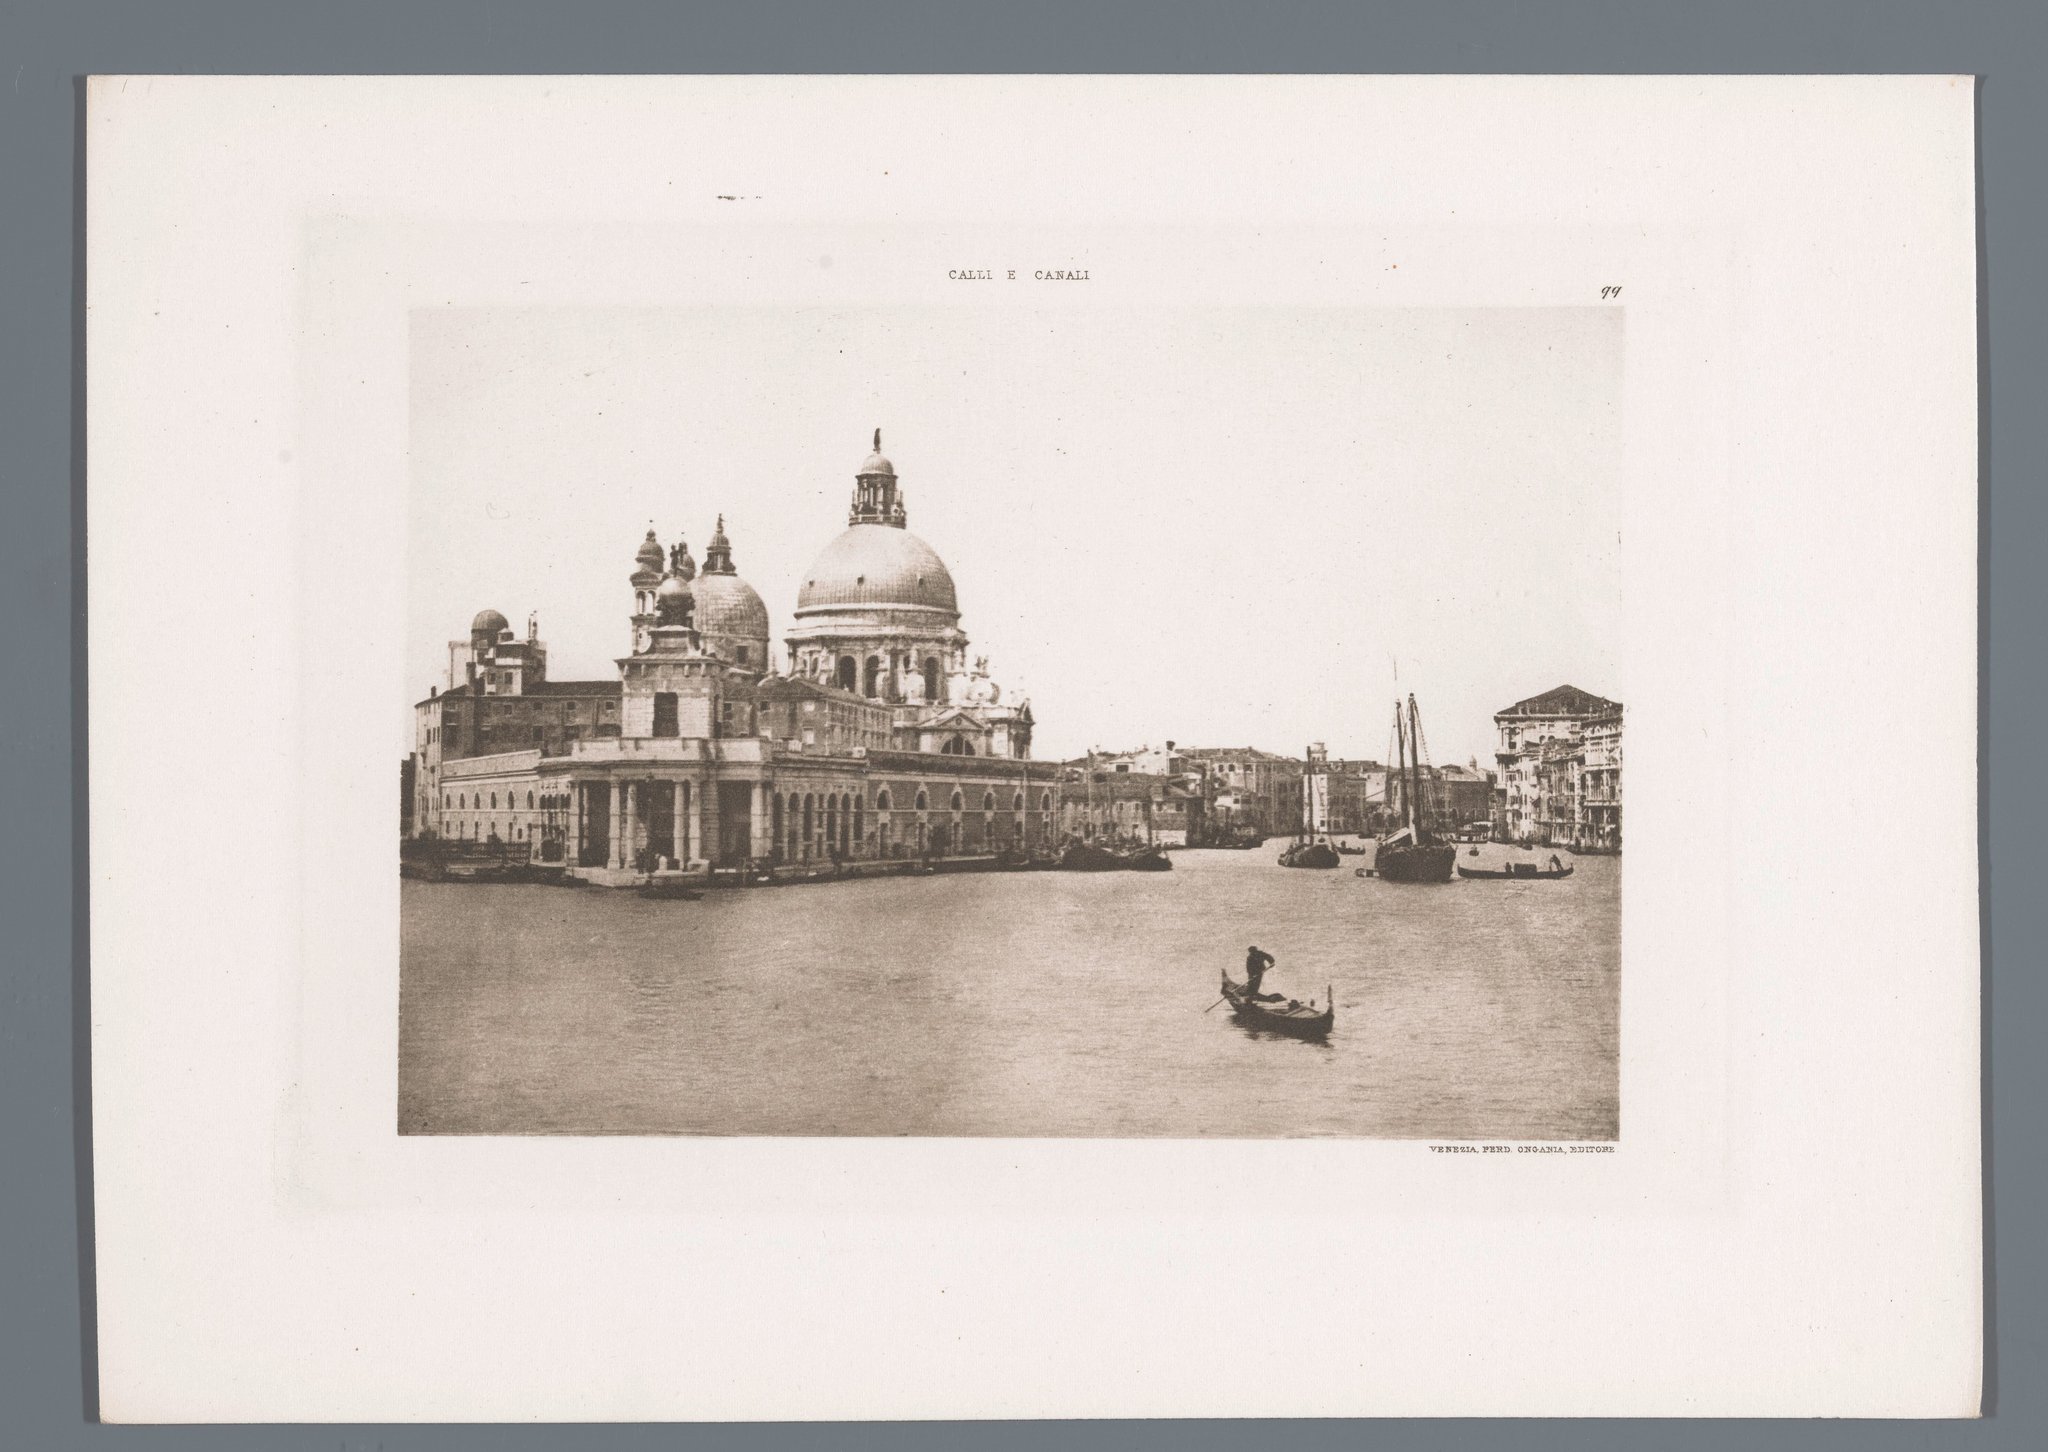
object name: page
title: Gezicht over het Canal Grande met Punta della Dogana en de Santa Maria della Salute in Venetië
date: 1888-1898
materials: paper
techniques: photoaquatint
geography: venice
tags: canals, waters (in city), bridge in city across river, canal, etc.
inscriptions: inscription: ‘qq’